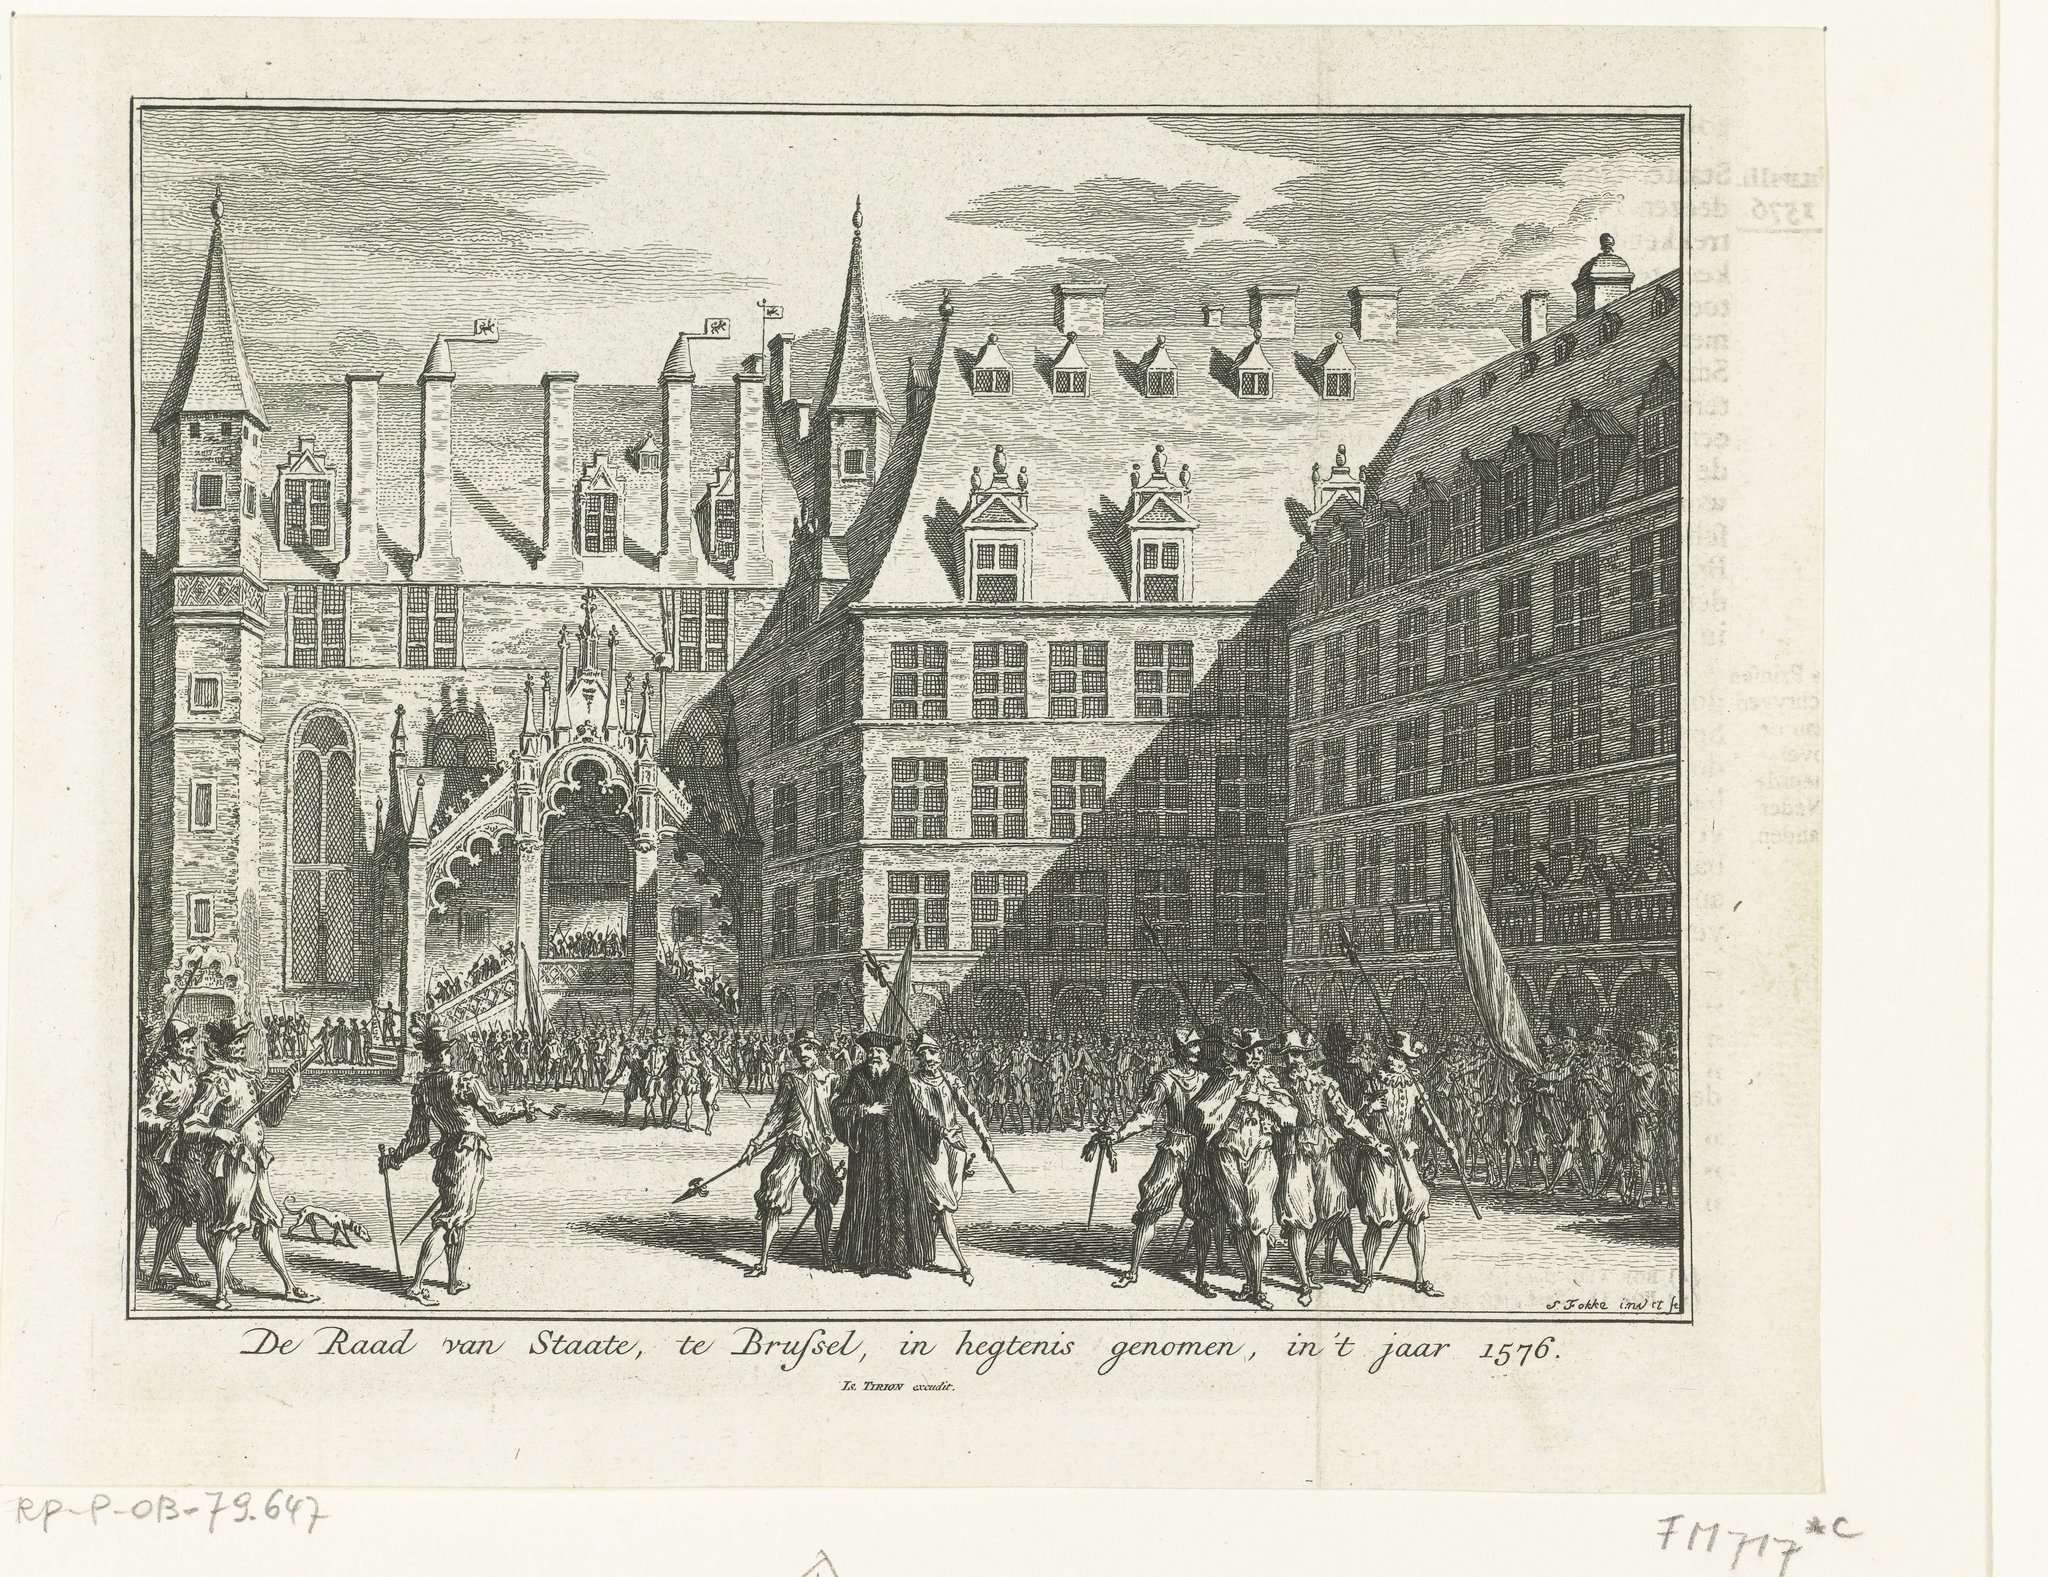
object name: print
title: De Raad van Staate, te Brussel, in hegtenis genomen, in 't jaar 1576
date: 1747-1759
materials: paper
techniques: etching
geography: northern netherlands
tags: charles de berlaymont, bruges, brussels, clergyman, criminal law; punishment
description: De leden van de Spaansgezinde Raad van State worden in Brussel gevangengenomen, 5 september 1576. Soldaten voren de leden van de Raad weg. Hiertoe behoren: Van Mansfeld, Berlaymont, Viglius en Del Rio.